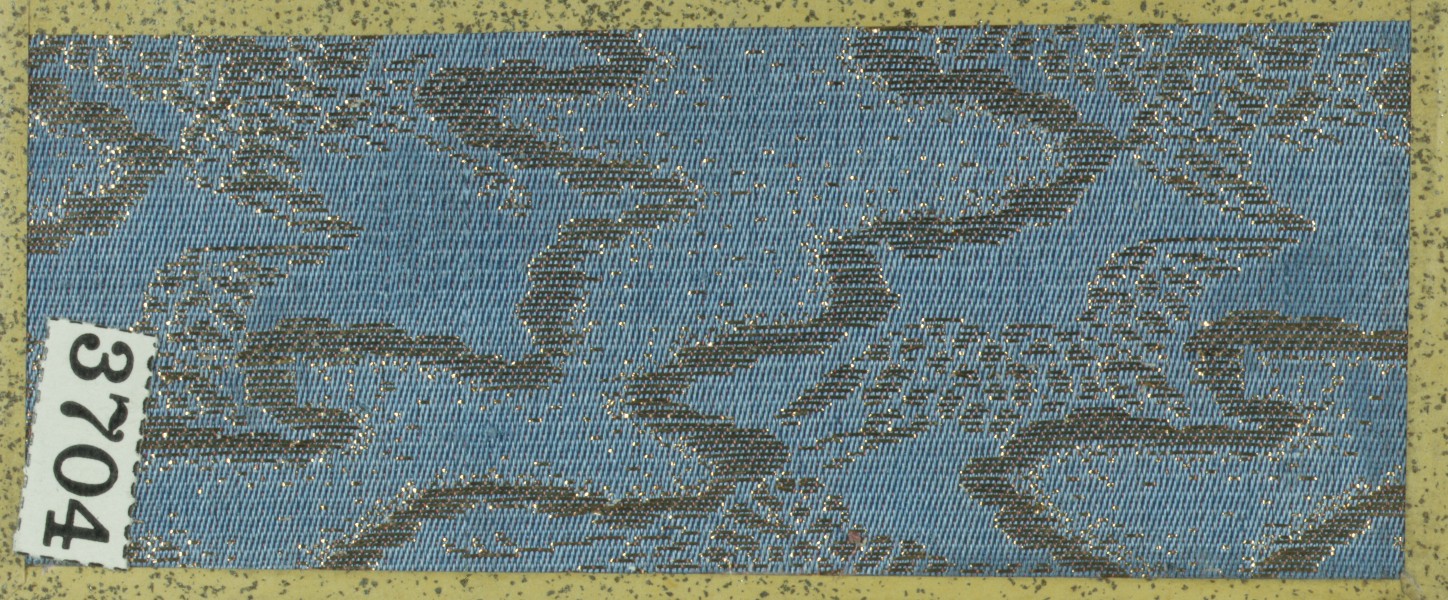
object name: sample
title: Textile Sample from Sample Book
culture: japanese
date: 1801-1900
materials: silk